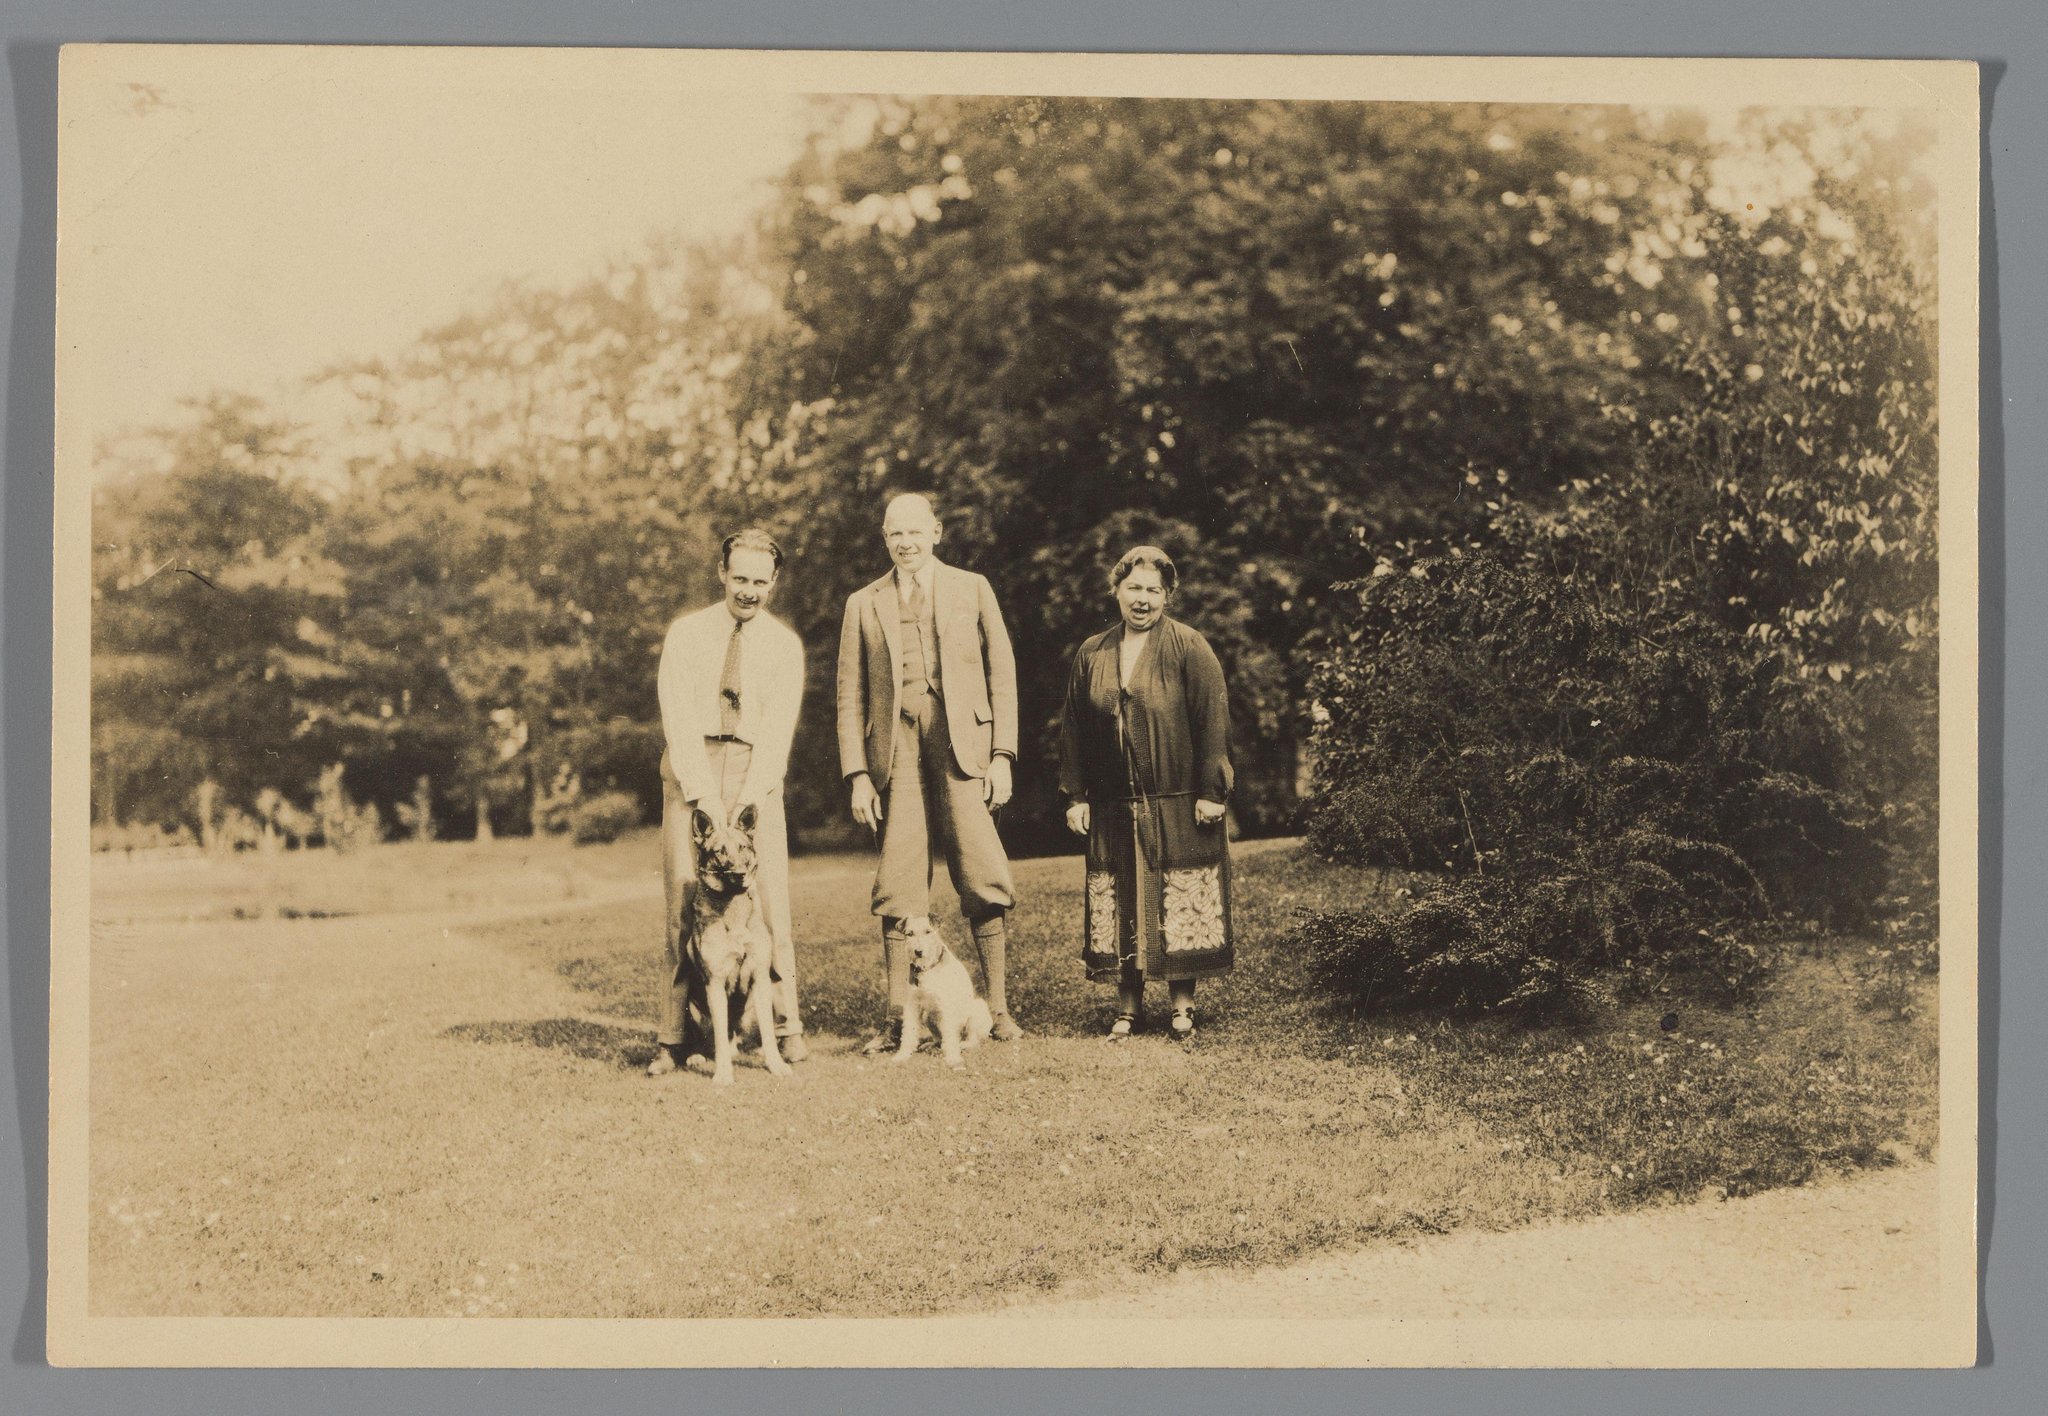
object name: photograph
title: Karel Frederik van den Berg, zijn echtgenoot en een onbekende met twee honden in een veld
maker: Anonymous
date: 1935-1945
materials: photographic support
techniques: photography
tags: batavia, karel frederik van den berg